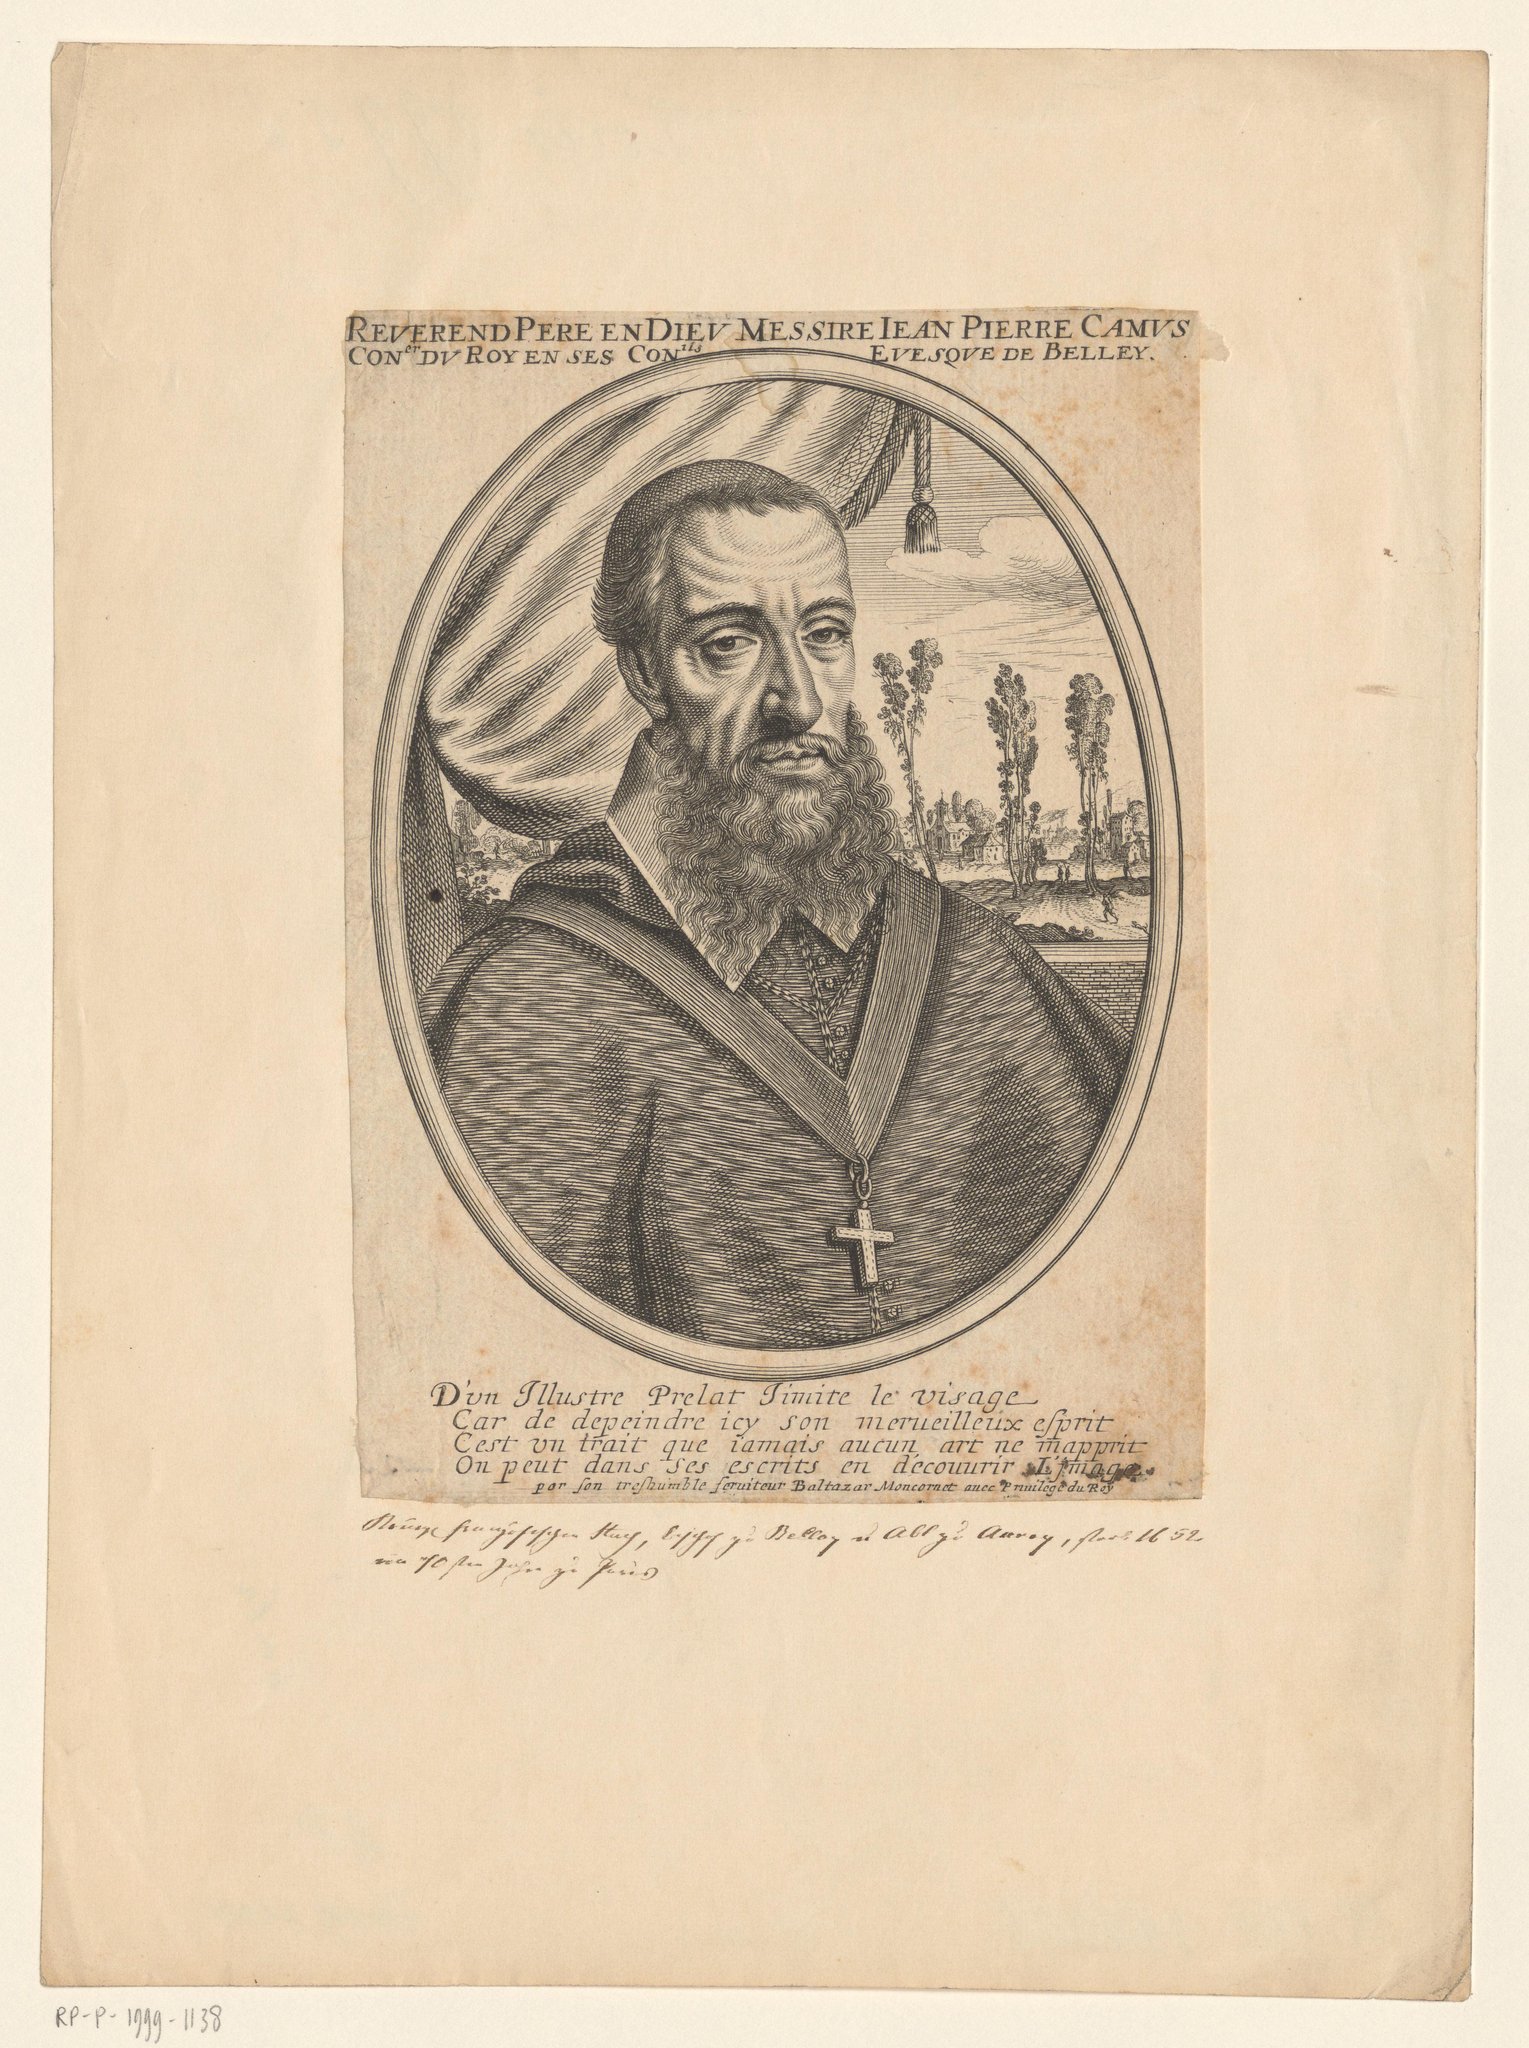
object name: print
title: Portret van Jean Pierre Camus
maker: balthazar moncornet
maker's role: print maker, publisher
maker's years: 1600-1668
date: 1610-1668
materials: paper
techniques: engraving, etching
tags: paris, historical persons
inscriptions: collector's mark: Lugt 2228